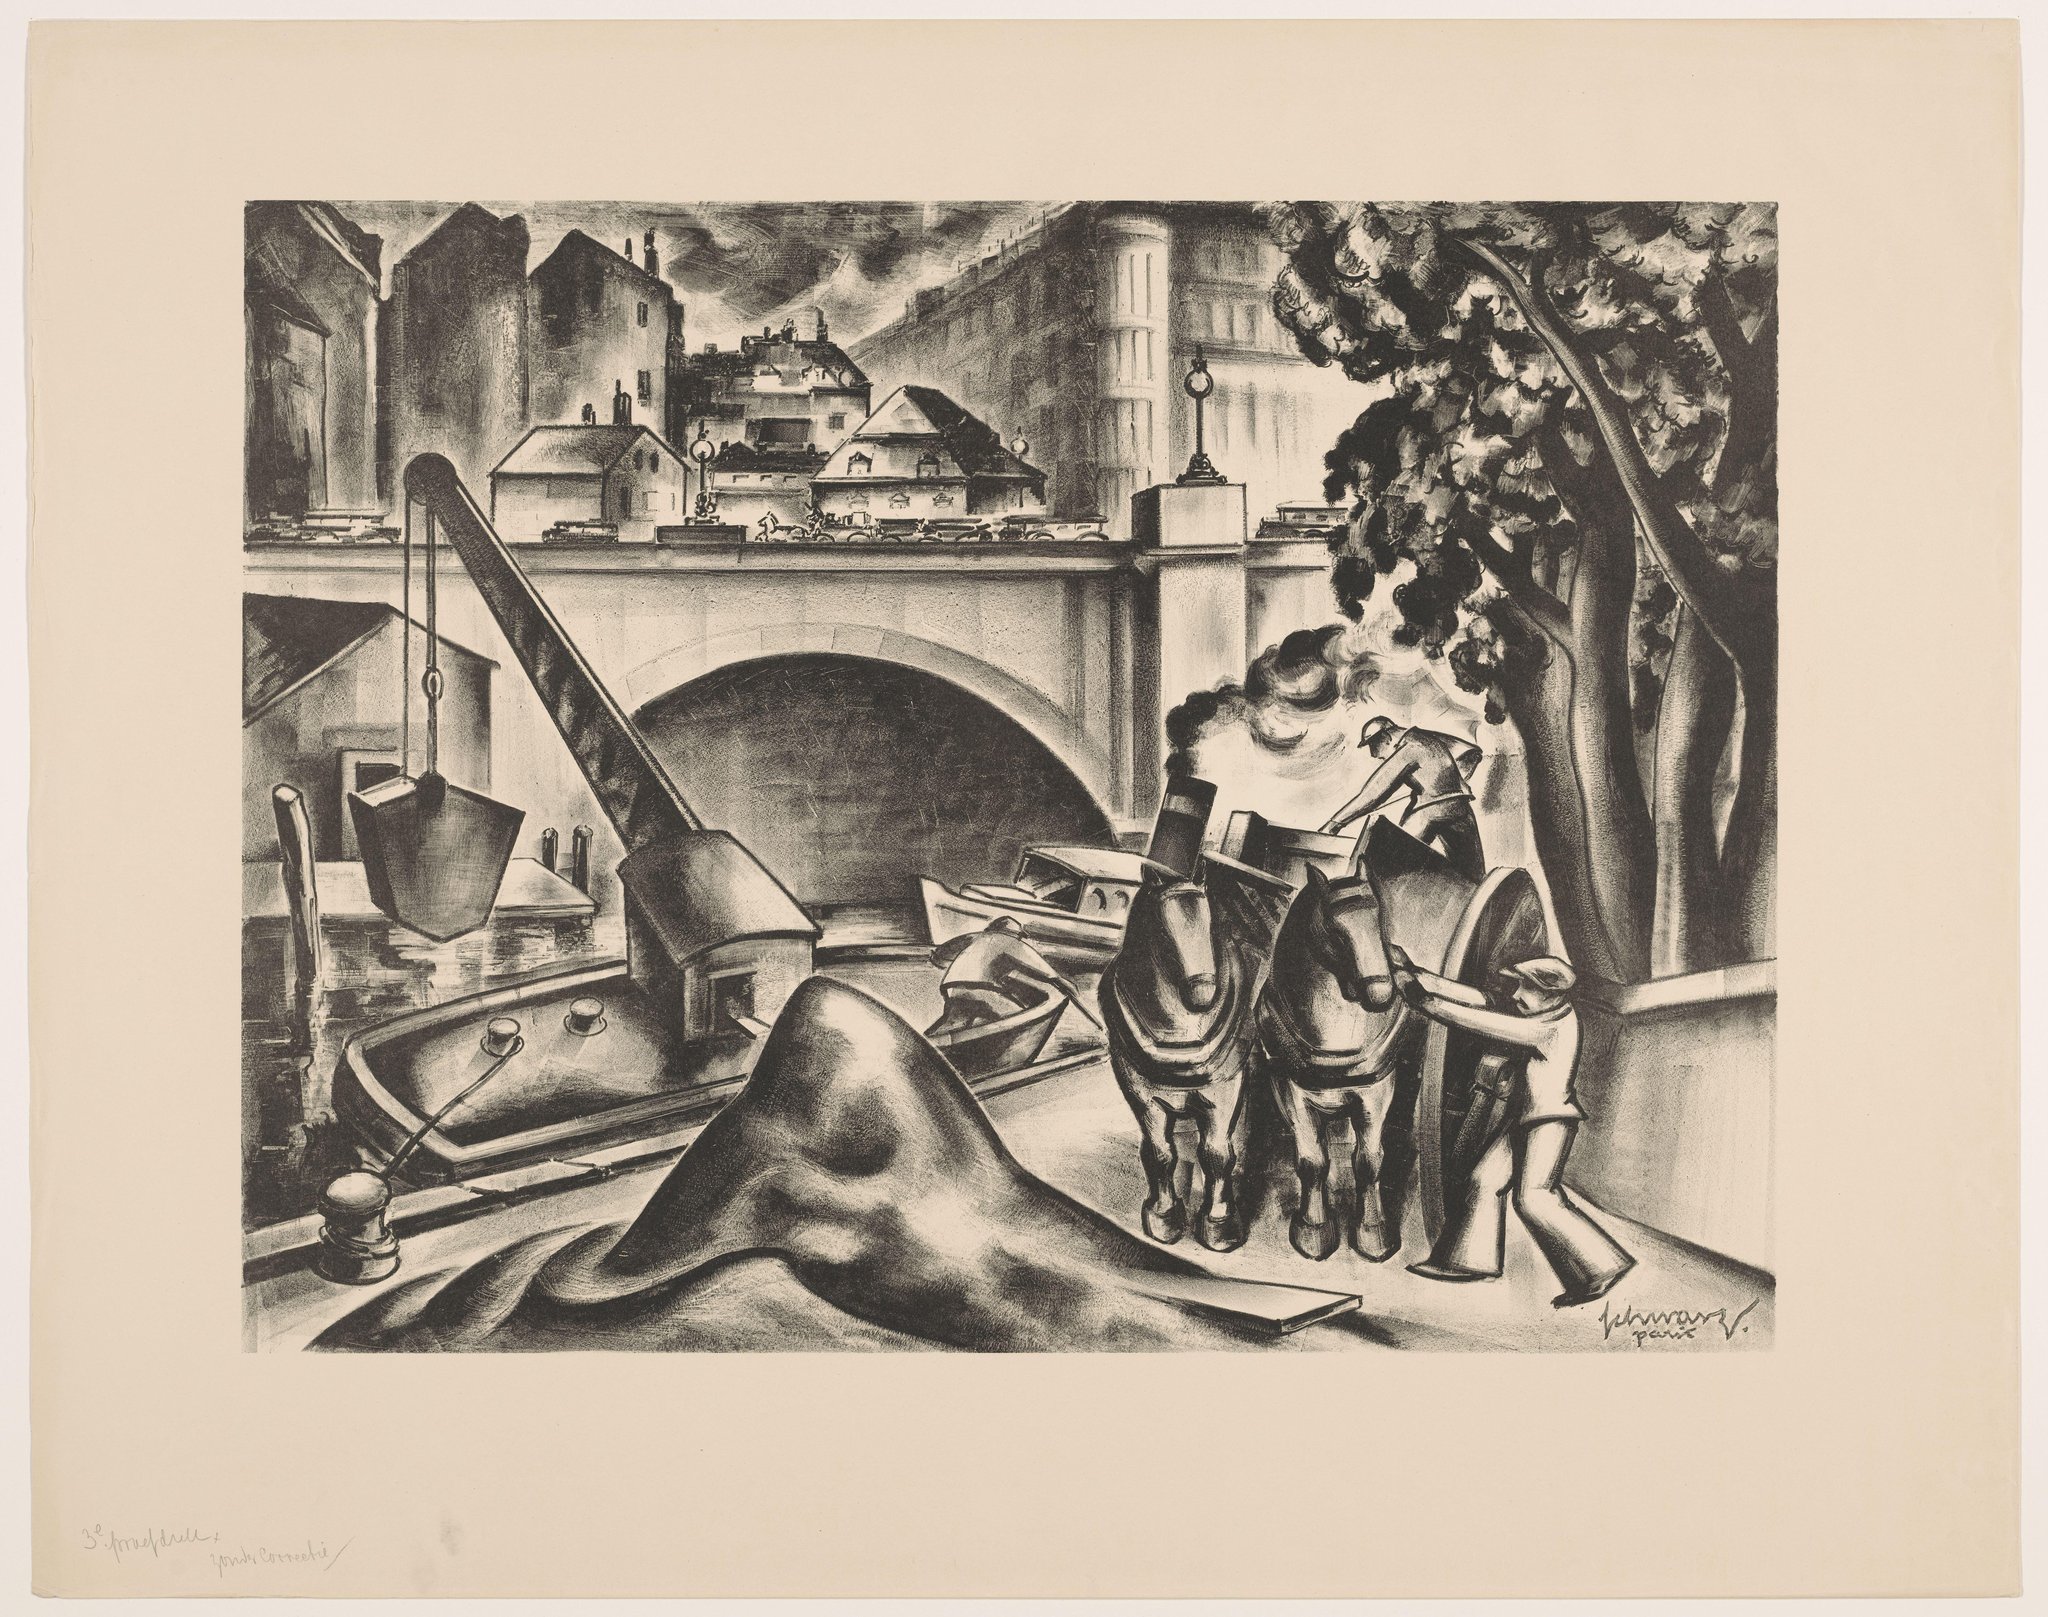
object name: print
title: Kade van de Seine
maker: mommie schwarz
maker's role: print maker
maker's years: 1876-1942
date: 1909-1910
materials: paper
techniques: lithograph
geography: paris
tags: trees, horse, bridge in city across river, canal, etc., paris